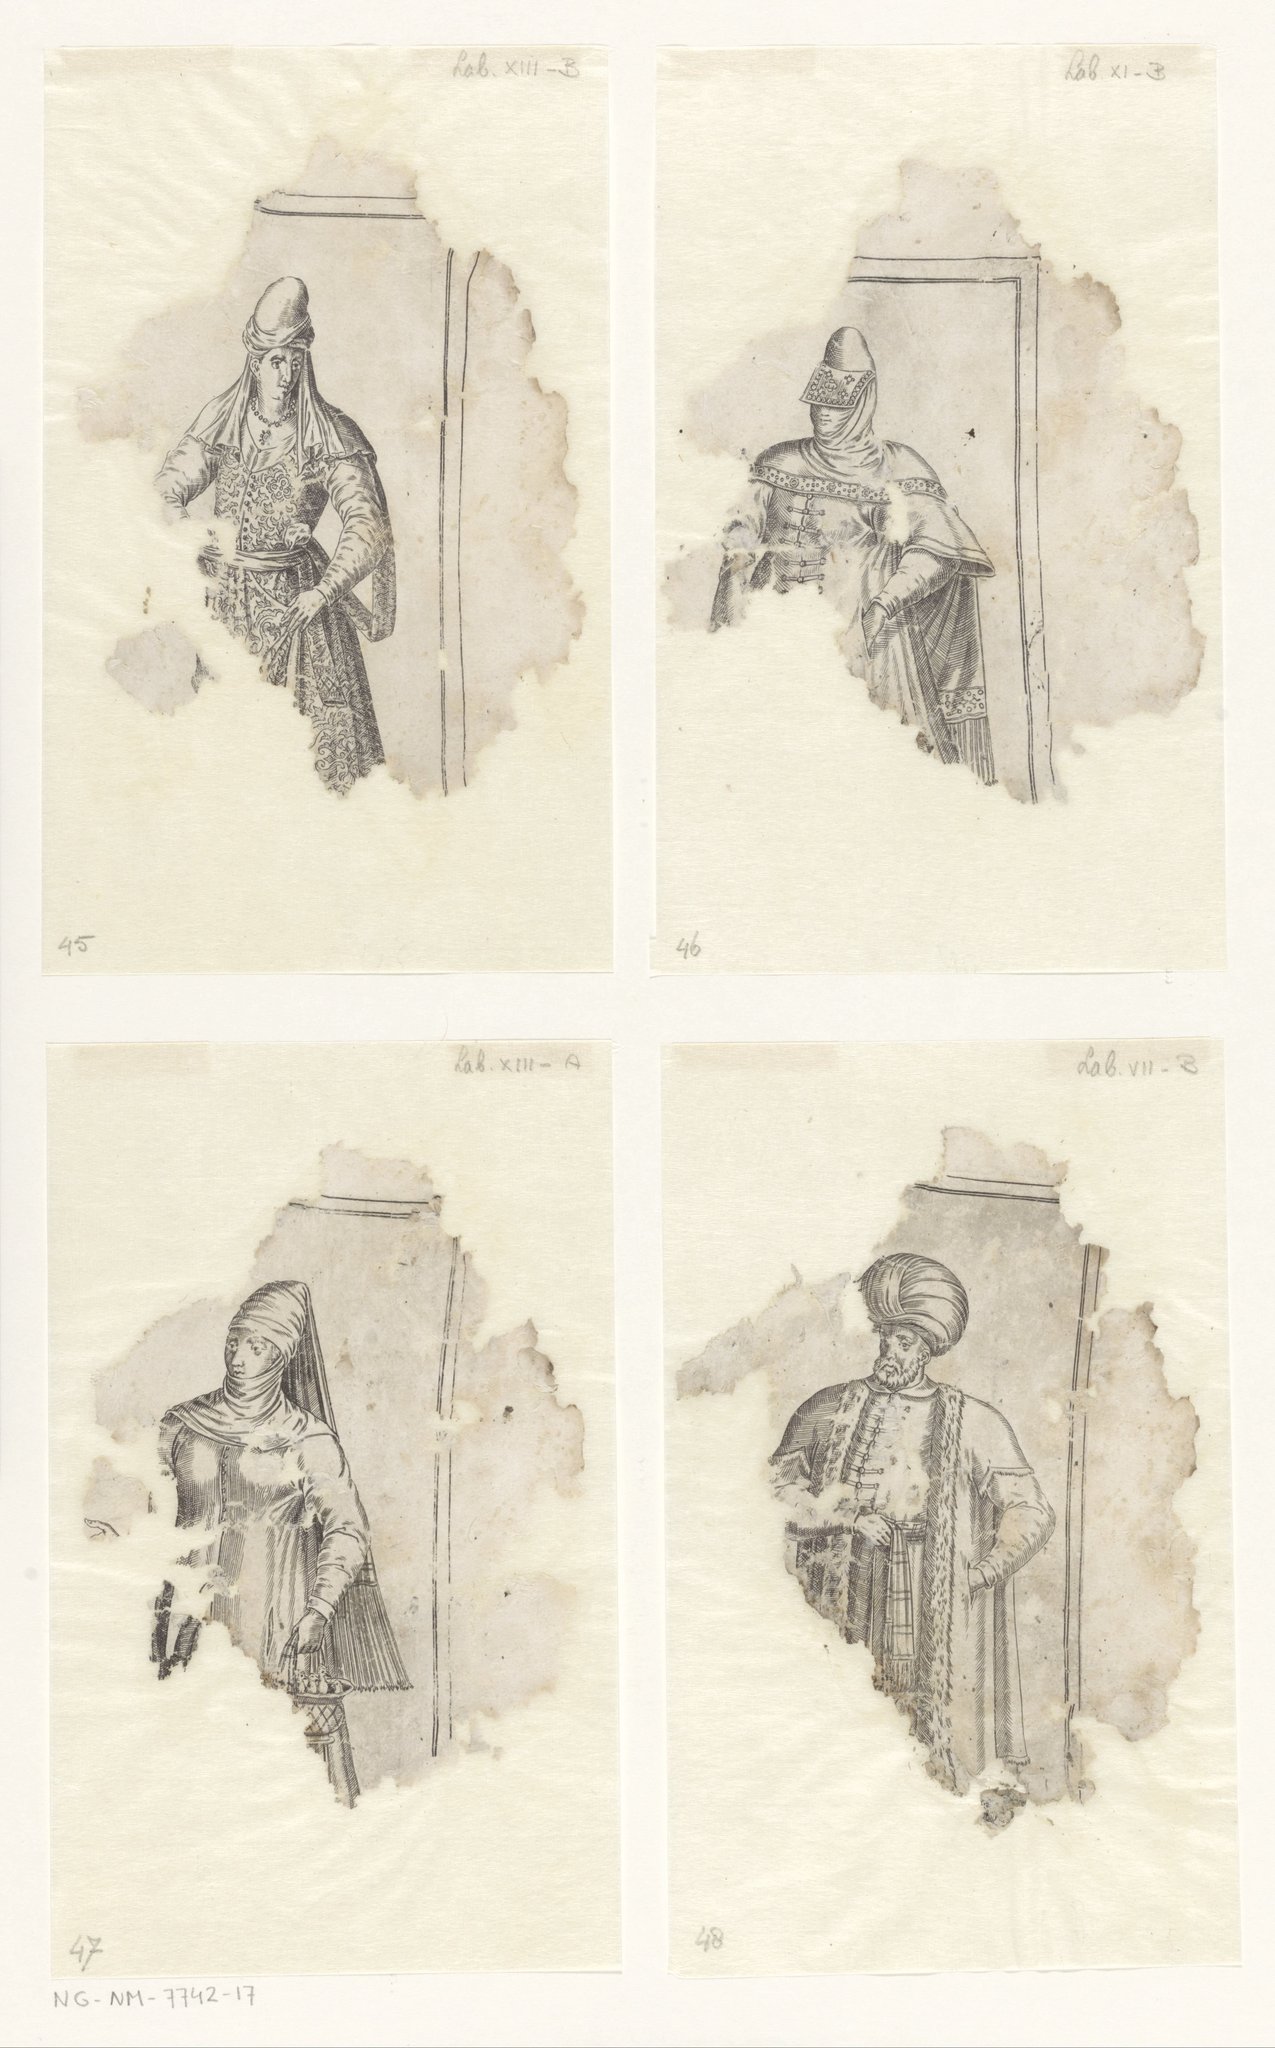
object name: costume print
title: Omnium pene Europae, Asiae, Aphricae atque Americae gentium habitus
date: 1581-1596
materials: paper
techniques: engraving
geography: cologne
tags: clothes, costume (+ women's clothes), clothes, costume (+ men's clothes)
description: De prenten in de Nova Zembla collectie zijn tijdens een expeditie van Willem Barendsz en Jacob van Heemskerk in 1596-1597 noodgedwongen in het winterkamp, het ‘Behouden Huis’, op het eiland achtergelaten. De prenten waren in één of meerdere stapels als handelswaar meegenomen vanuit Amsterdam. Bijna drie eeuwen later, in 1871, keerde de Noor Elling Carlsen terug naar Nova Zembla en vond daar de restanten van het ‘Behouden Huis, inclusief een groot deel van de inventaris. Een deel van de prenten, in de vorm van aaneengekoekte kluiten, werd toen ook teruggevonden. De papierkluiten waren soms op meerdere plekken gebroken. Tussen 1975-1979 zijn de prenten van elkaar gescheiden. Dit leverde in totaal ca. 1000 fragmenten van ca. 400 afdrukken van ca. 150 verschillende prenten op. Voor zover mogelijk zijn de fragmenten samengevoegd en zijn de prenten gereconstrueerd.